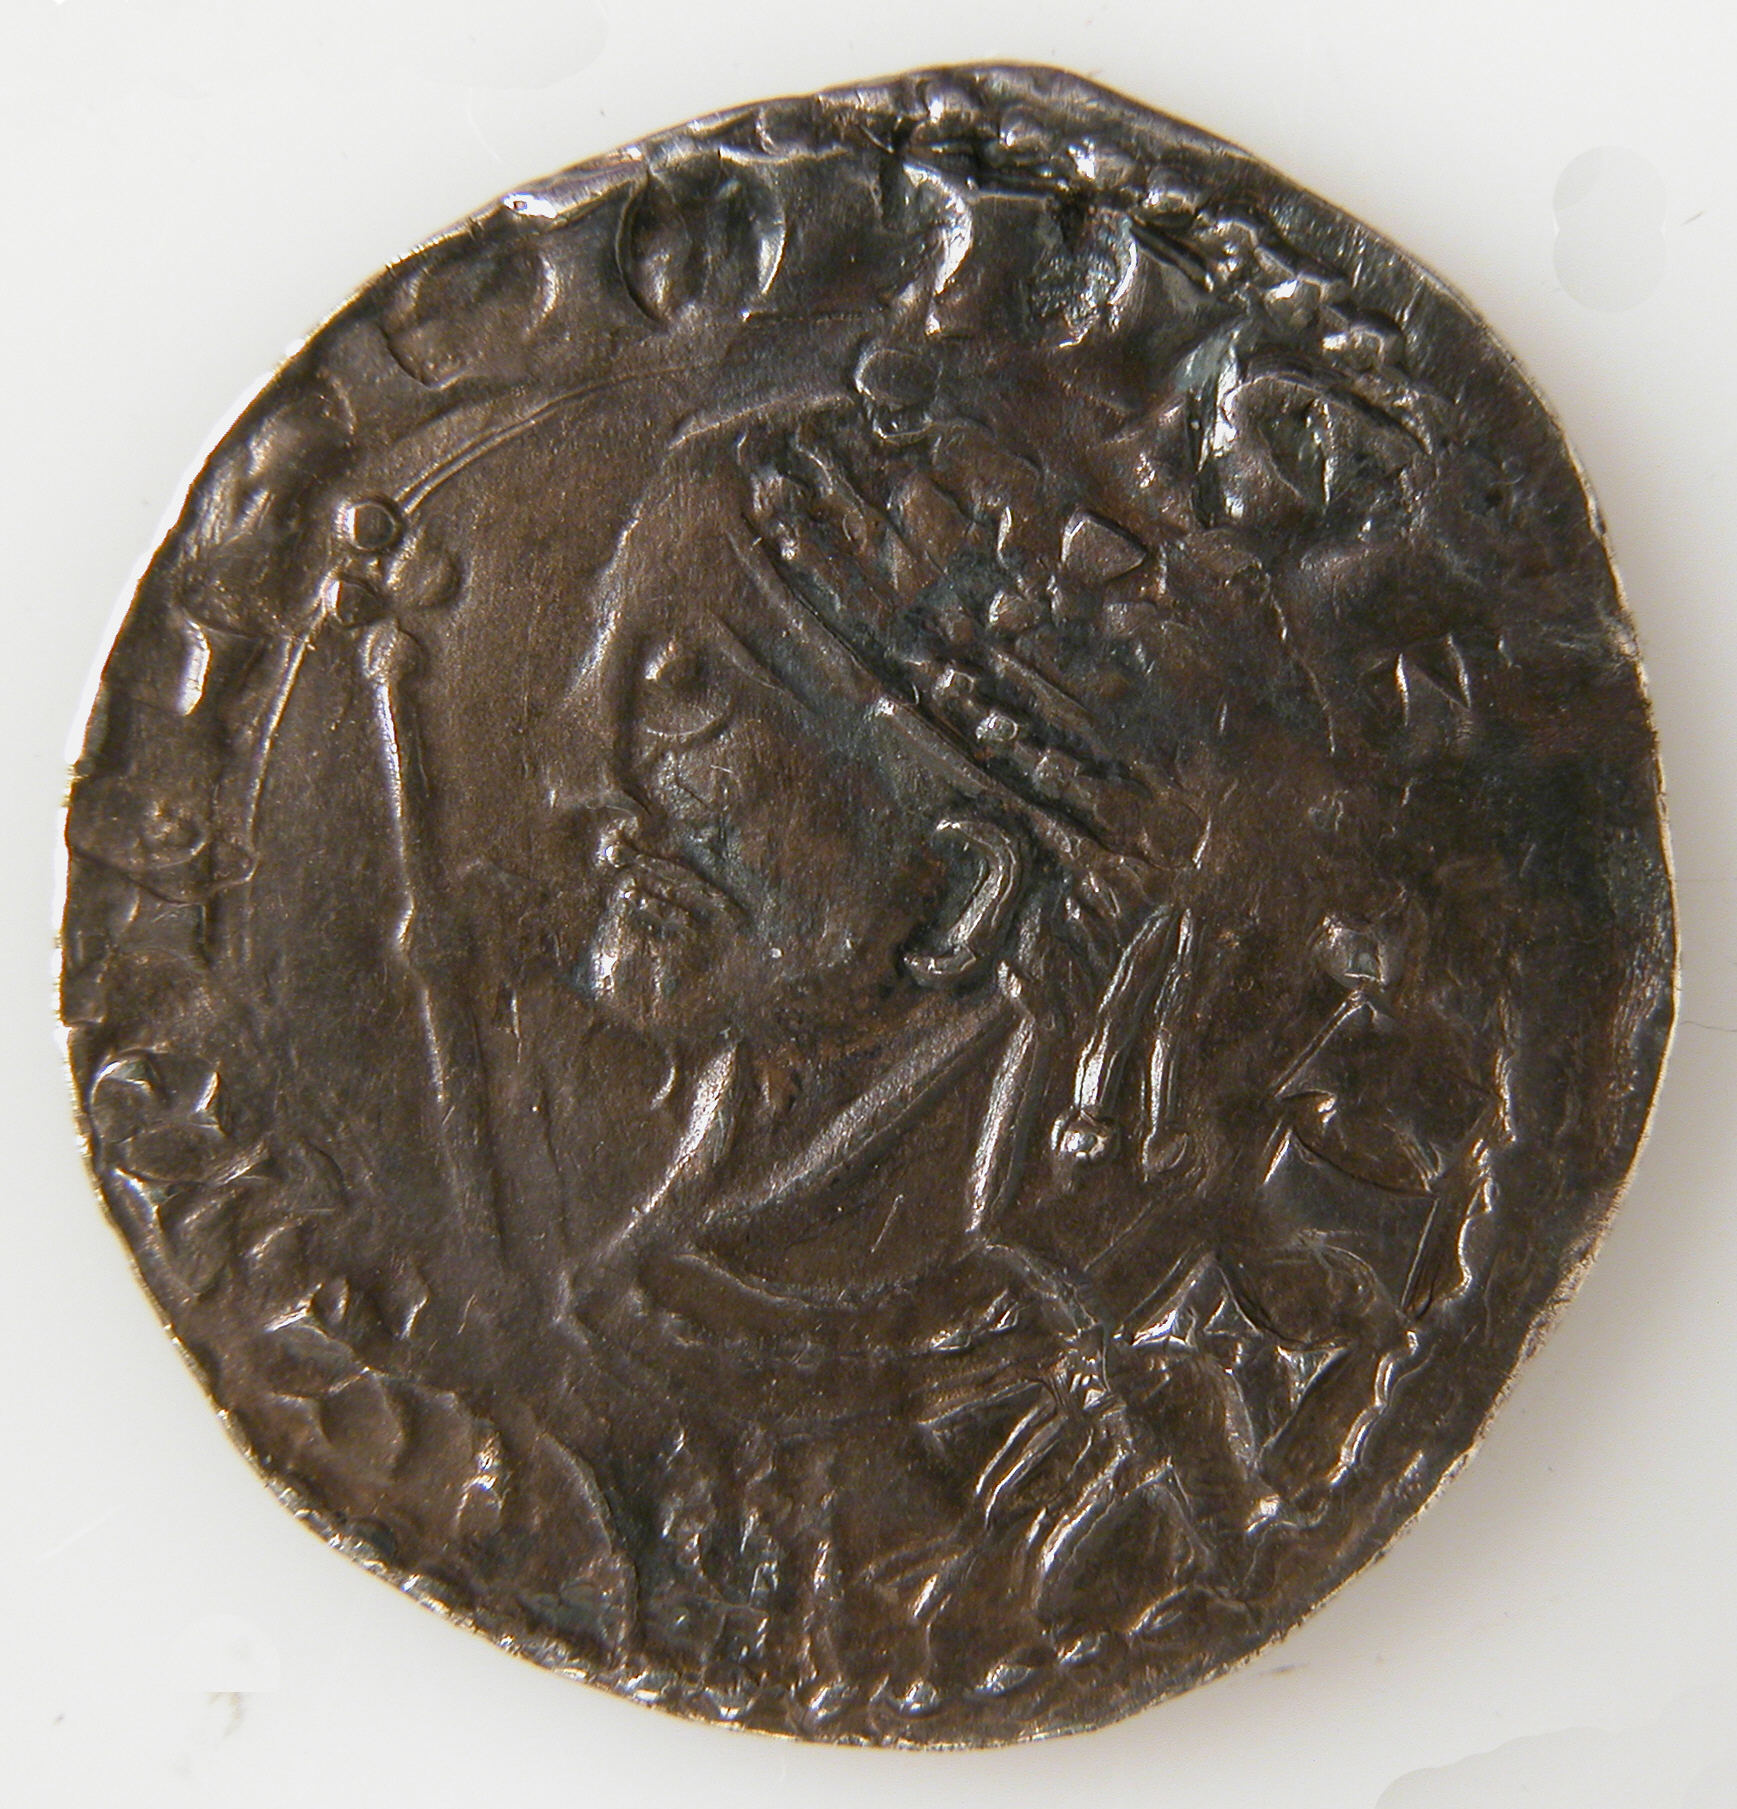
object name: coin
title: William I Penny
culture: british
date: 1066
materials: silver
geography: england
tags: kings,profiles,coins